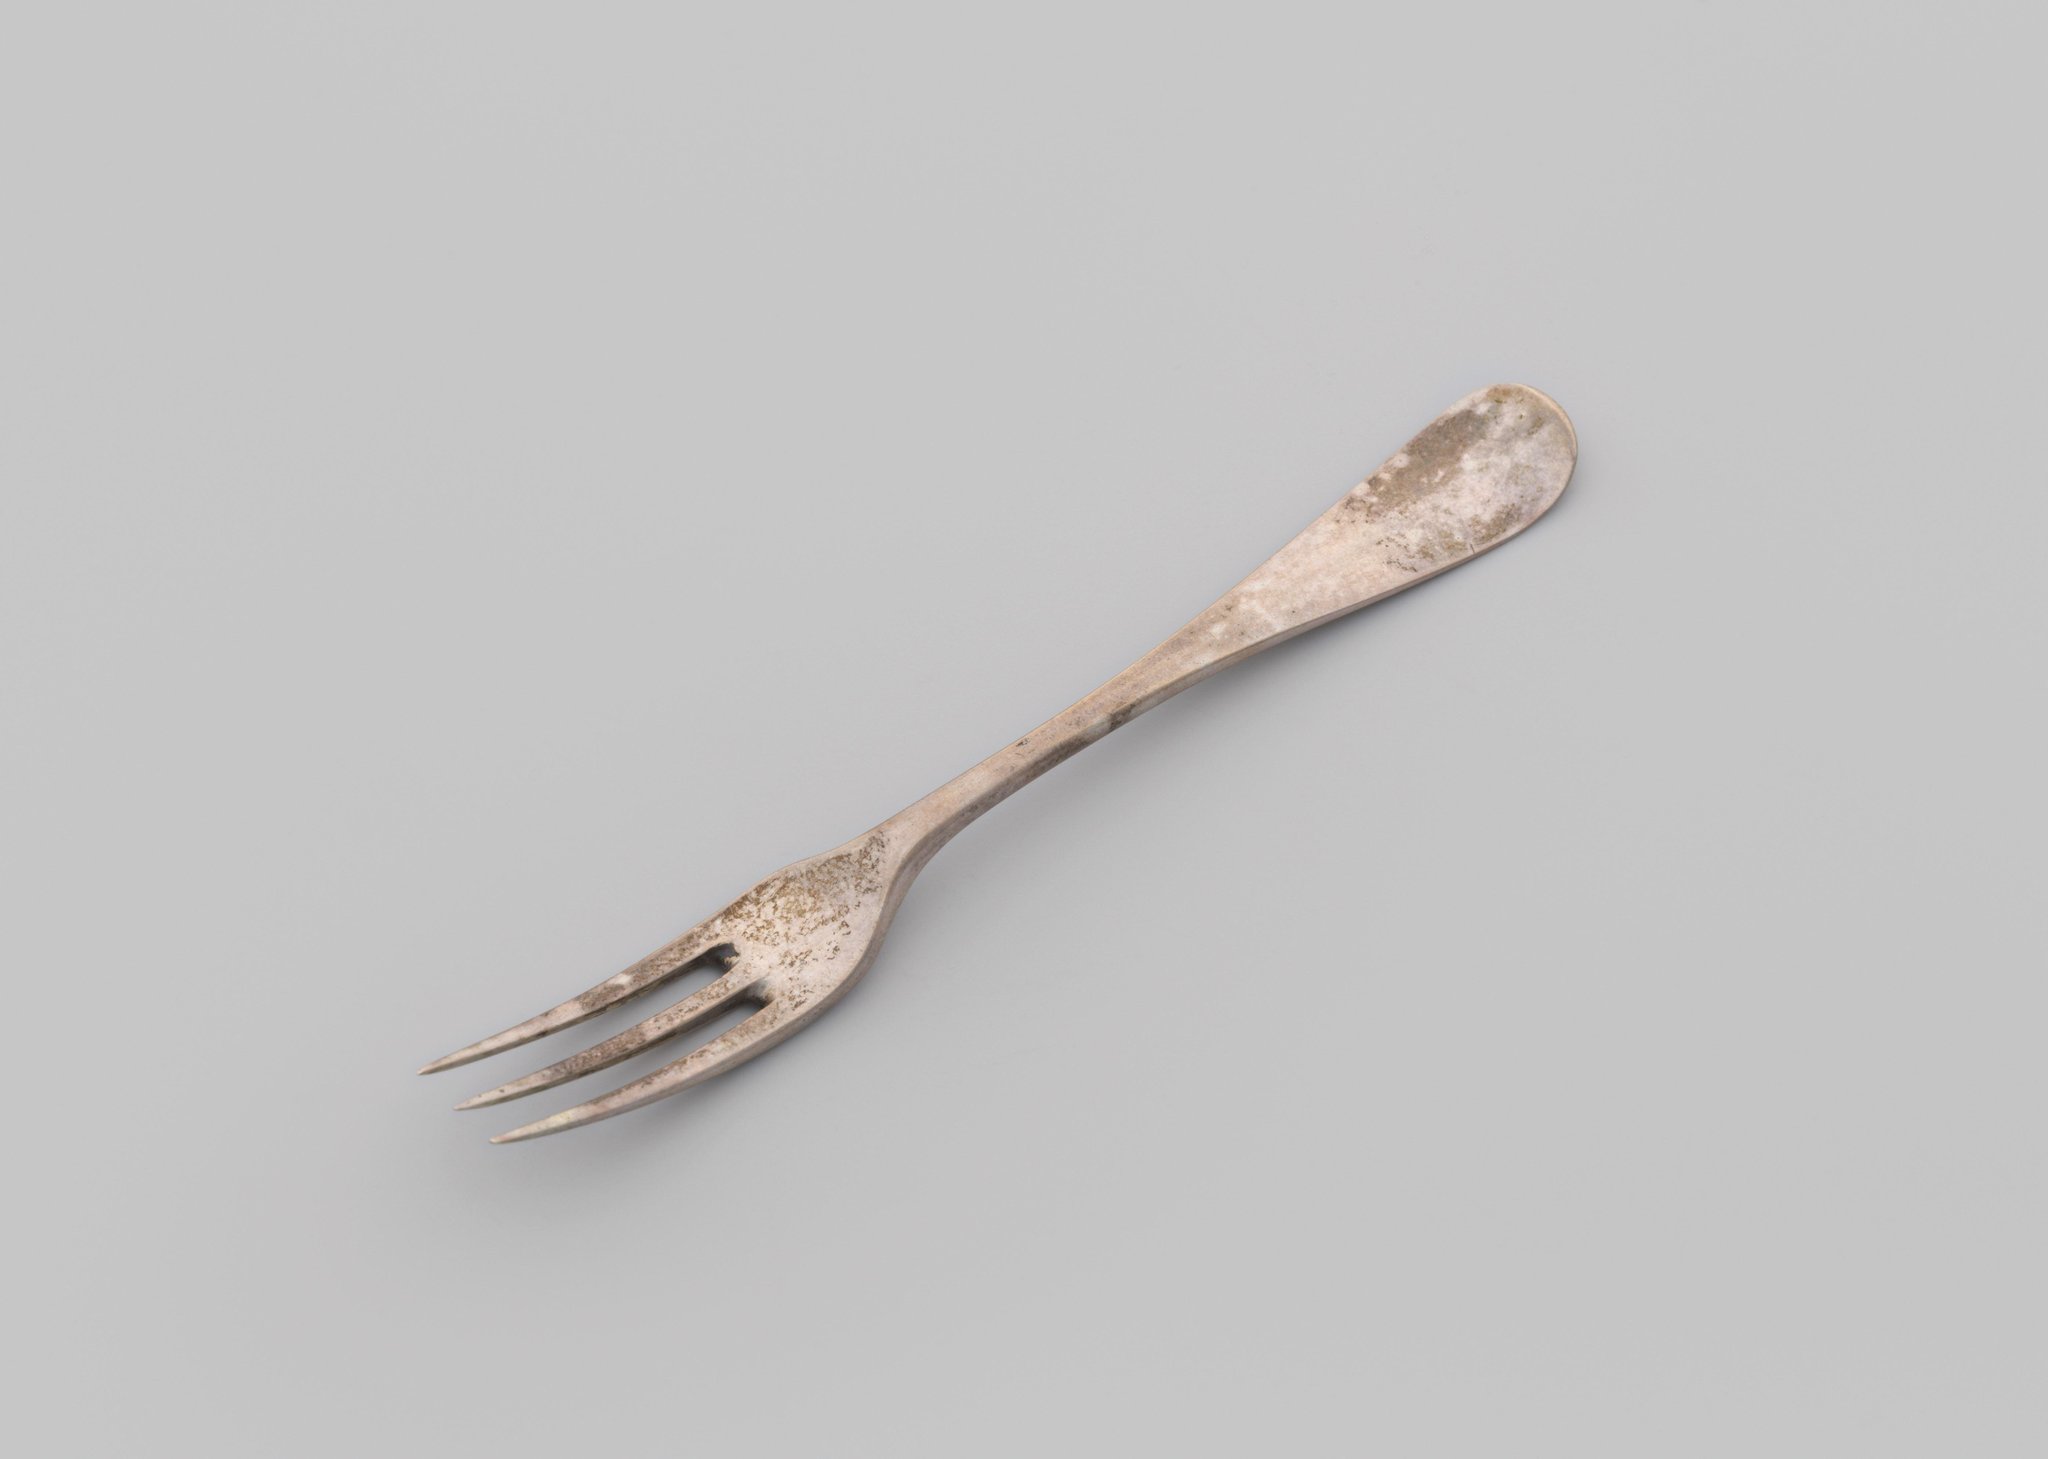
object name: fork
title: Vork van zilver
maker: a. keun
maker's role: silversmith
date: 1821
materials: silver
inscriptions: mark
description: Vork van zilver, met 3 tanden. De platte, gebogen steel verbreedt zich naar het afgeronde uiteinde.